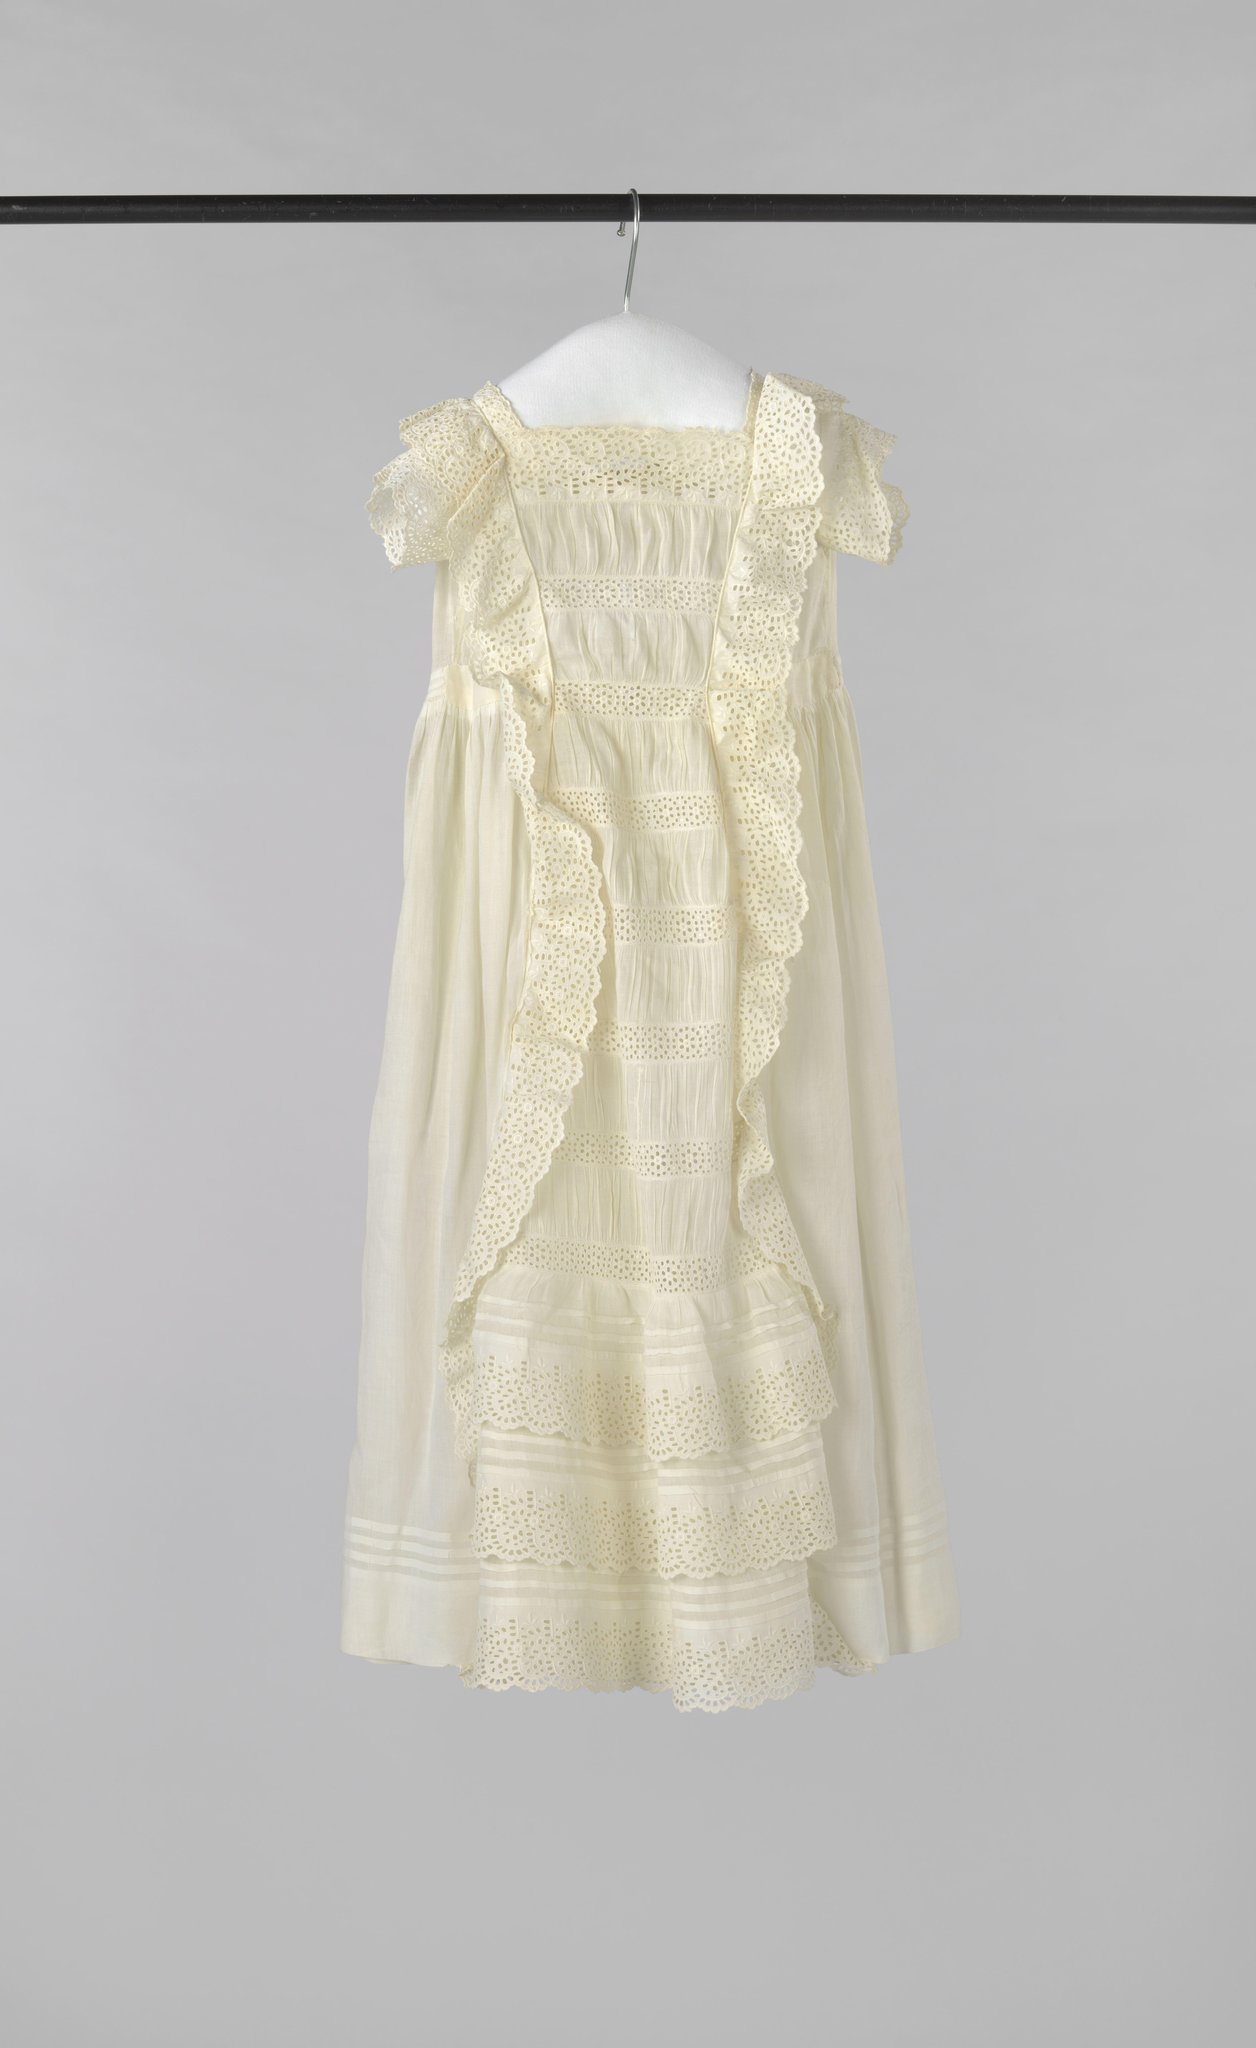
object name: childrenswear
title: Kinderjurk van wit katoen met tussenzetsels, ruches en korte mouwen van Engels borduurwerk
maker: Anonymous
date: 1850-1900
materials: cotton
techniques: embroidered, embroidery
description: Kinderjurk van wit katoen met tussenzetsels, ruches en korte mouwen van Engels borduurwerk. Plooien en oprijgen. De jurk is mogelijk een doopjurk.